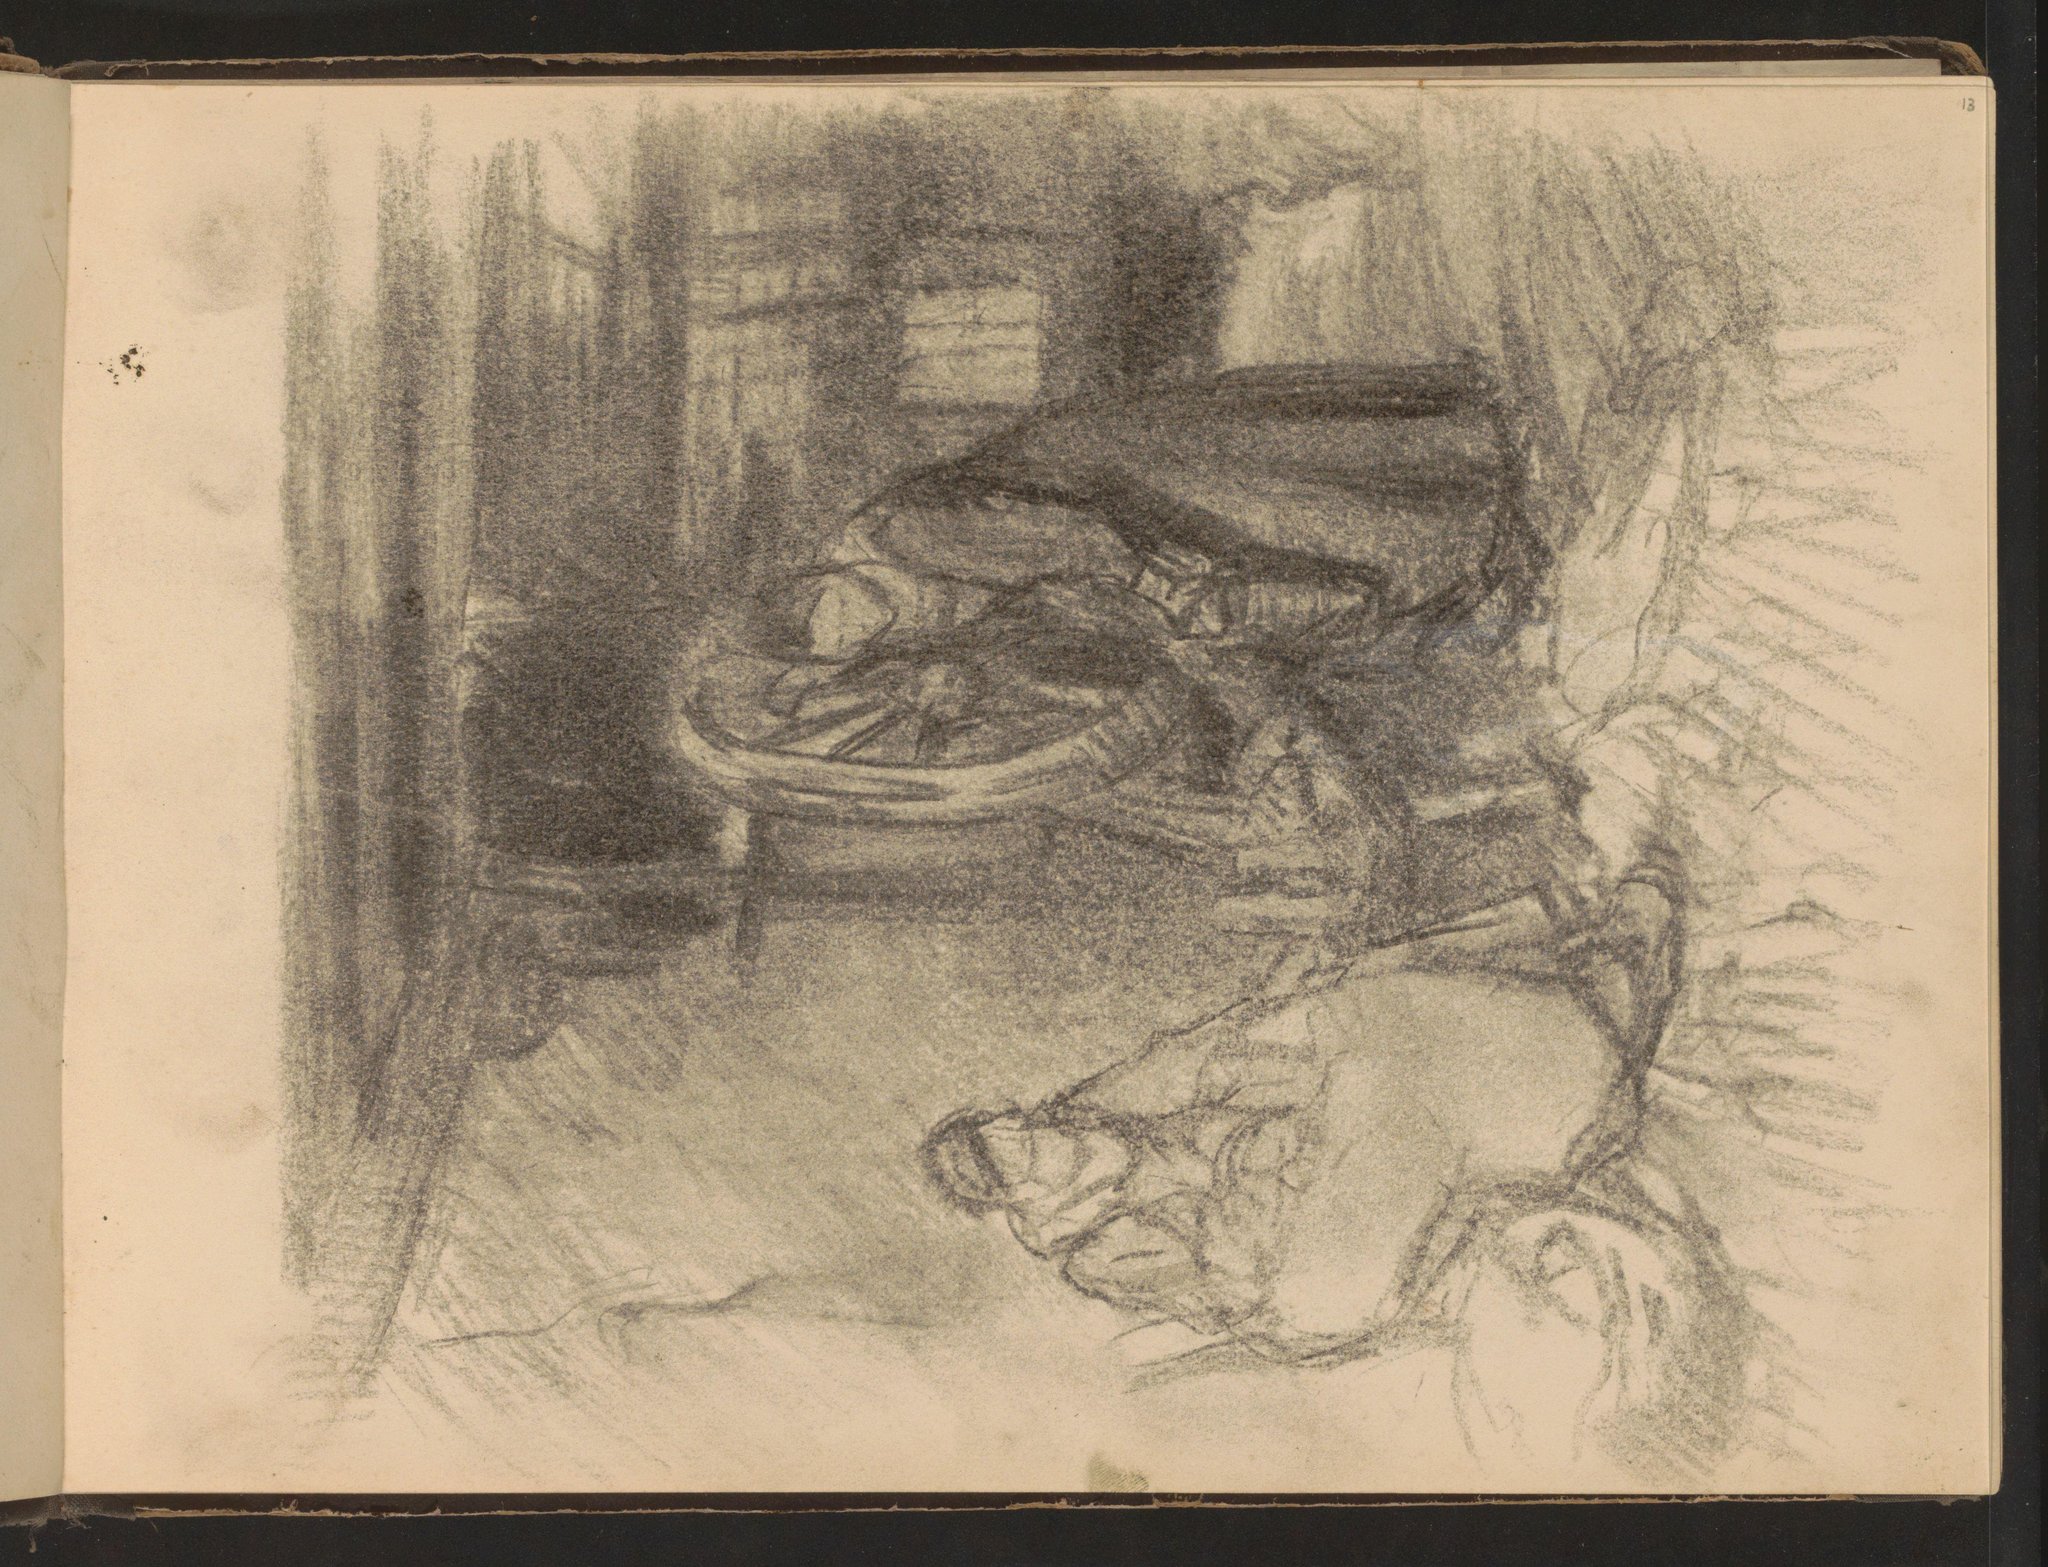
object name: sketchbook leaf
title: Boereninterieur met een vrouw bij een spinnewiel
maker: albert neuhuys (1844-1914)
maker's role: draughtsman, painter, print maker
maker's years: 1844-1914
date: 1854-1914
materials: charcoal, paper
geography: laren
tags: adult woman, rural housing, e.g. country-house, villa, cottage, spinning-wheel, interior of the house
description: Op de voorgrond een tweede vrouw, zittend in een stoel. Blad 13 recto uit een schetsboek met 43 bladen.